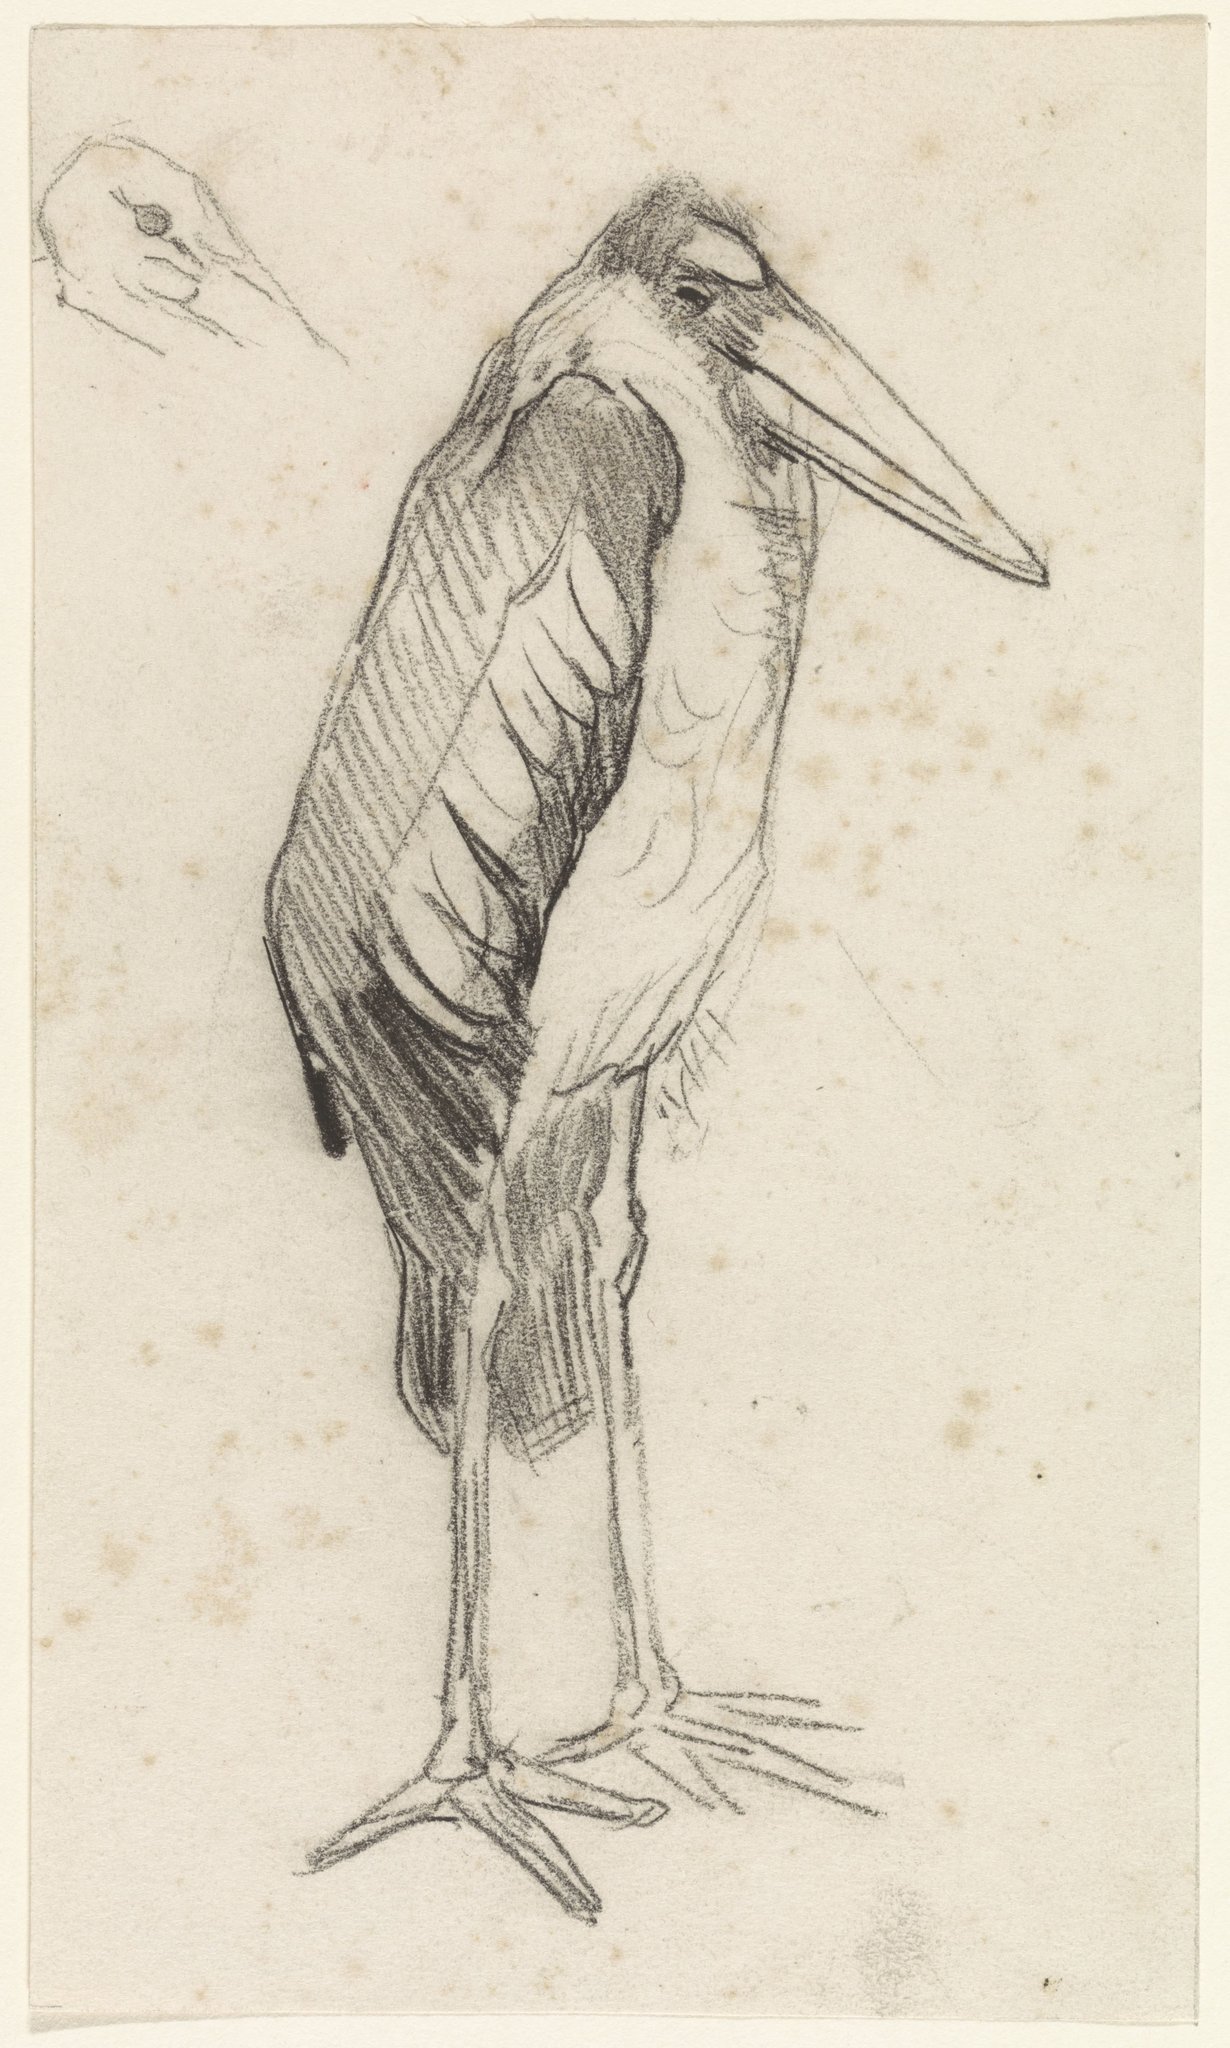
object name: drawing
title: Maraboe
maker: jan van essen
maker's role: draughtsman, print maker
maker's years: 1854-1936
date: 1864-1936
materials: chalk, paper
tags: shore-birds and wading-birds: marabou